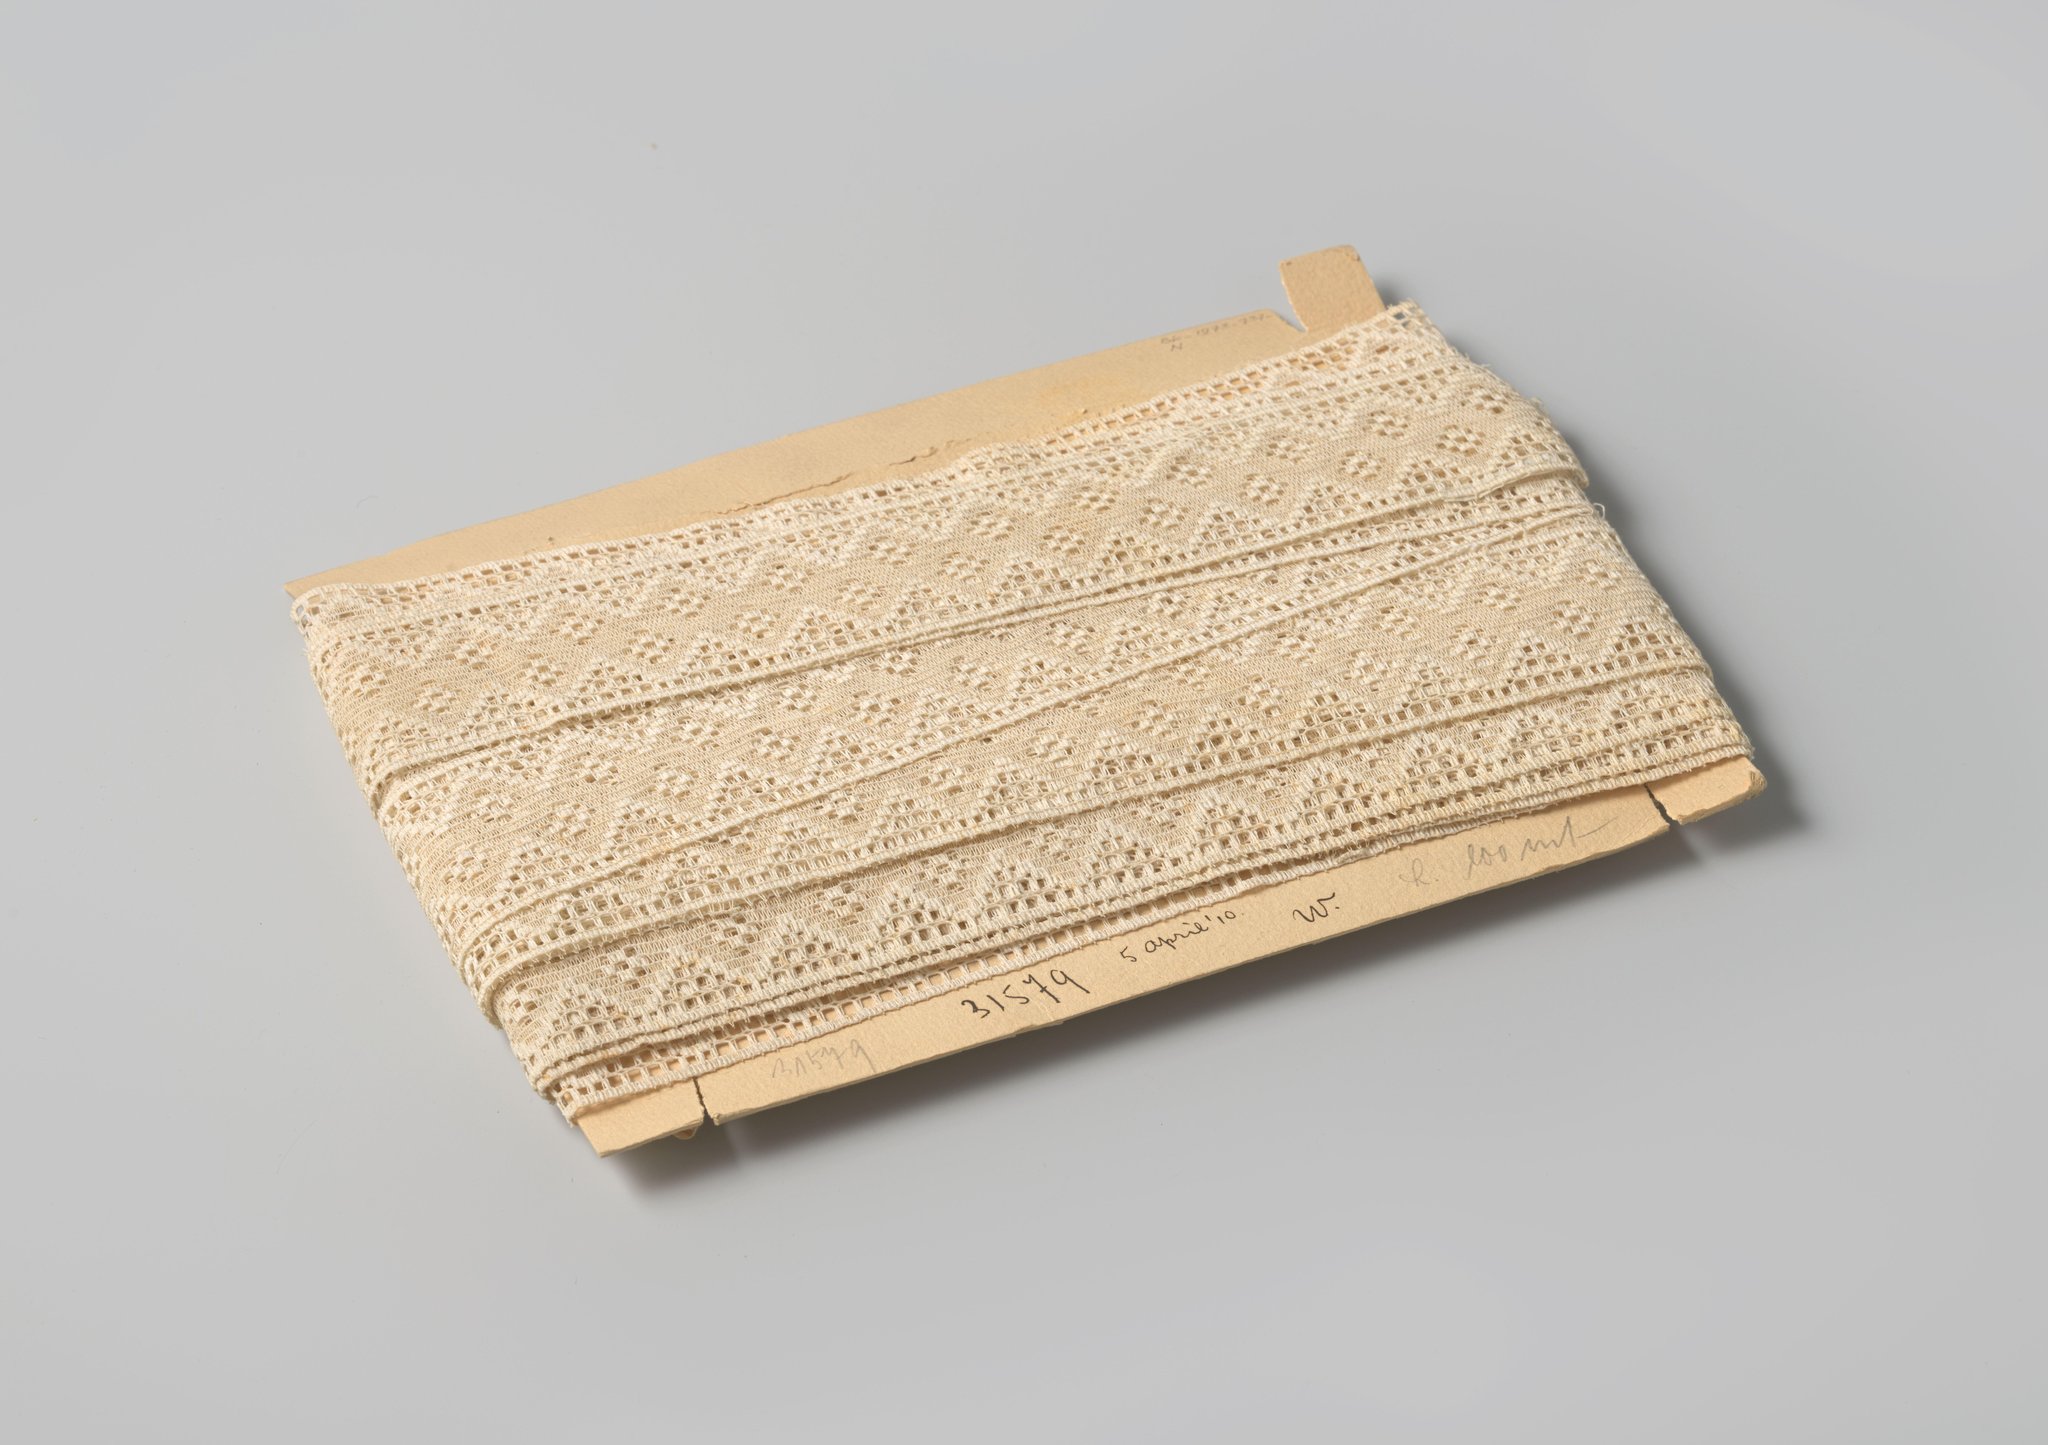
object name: entre deux, tussenzetsel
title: Tussenzetsel, wit, met een motief van vierkanten en ruiten op karton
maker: gustav schnitzler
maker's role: paraplufabrikant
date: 1925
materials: cardboard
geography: nijmegen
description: Metrages kant en passement, in wit en zwart en andere kleuren. Karton met witte entre-deux.